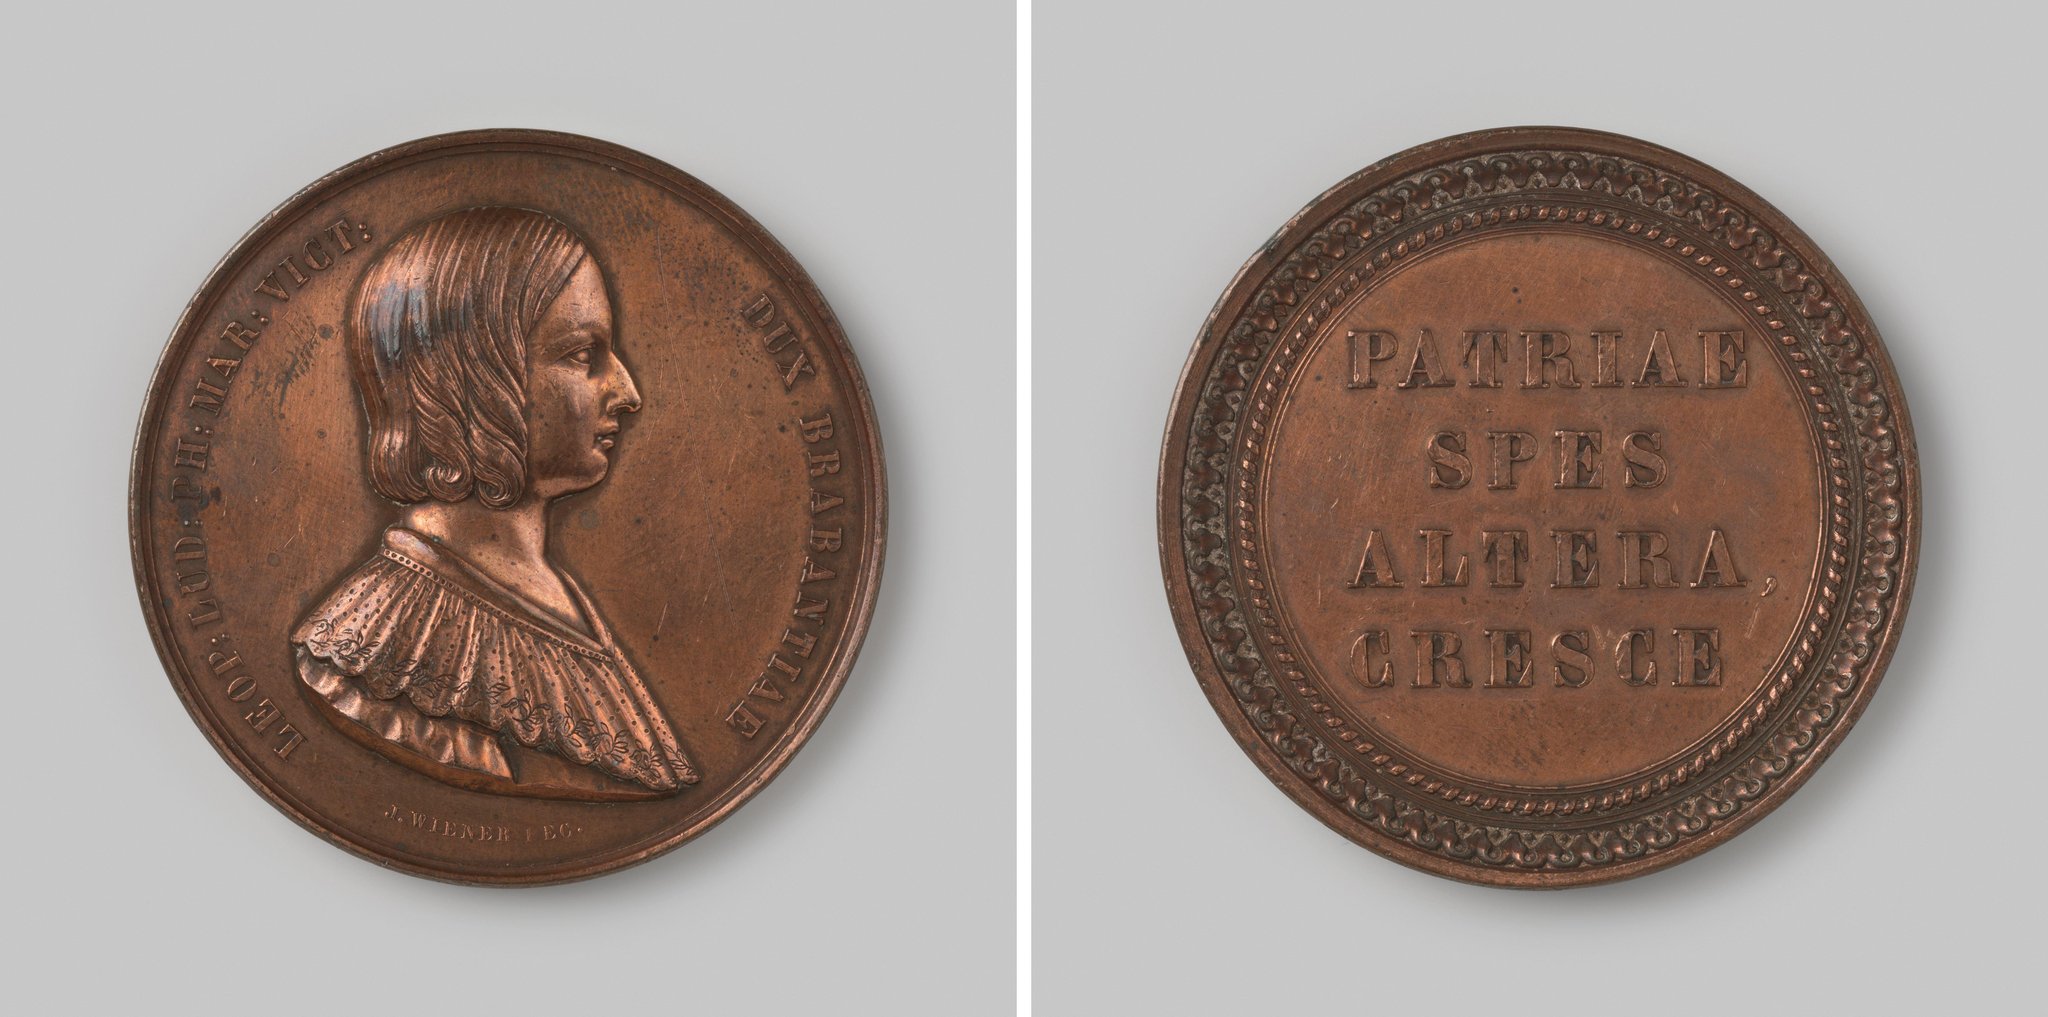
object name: history medal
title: Kroonprins Leopold van België 8 jaar oud 1843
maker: leopold wiener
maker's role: sculptor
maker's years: 1823-1891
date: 1843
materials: bronze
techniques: striking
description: Bronzen penning, op de voorzijde het borstbeeld van Leopold naar rechts met omschrift, op de keerzijde vier regels tekst binnen een versierde rand.